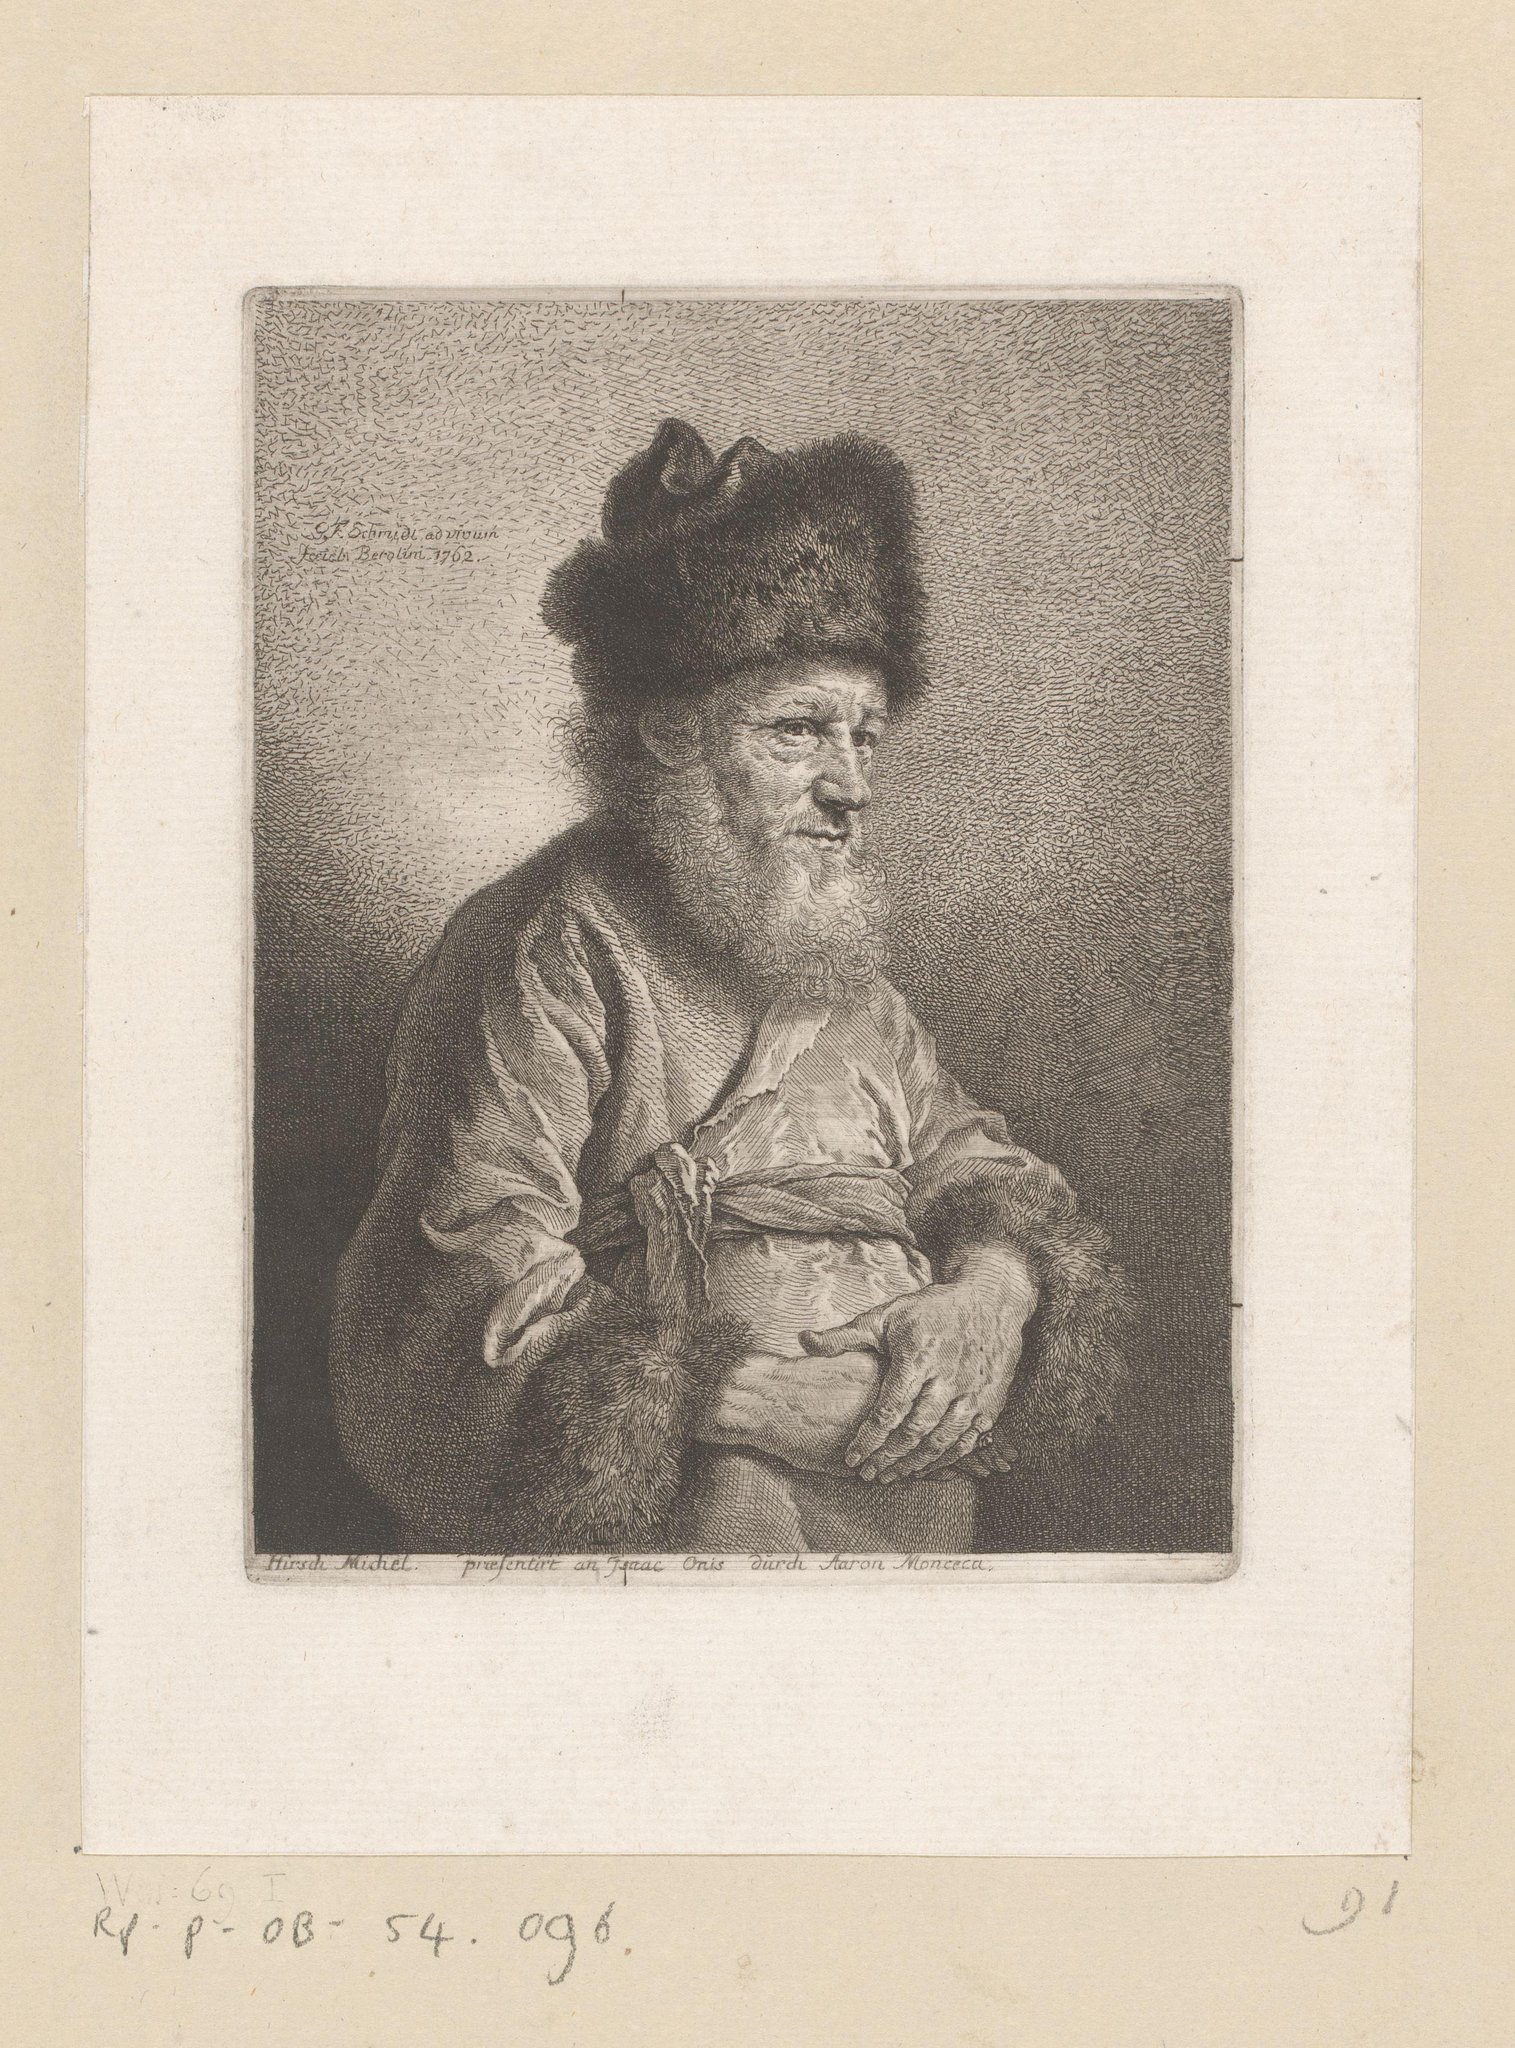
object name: print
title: Portret van Michel Hirsch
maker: georg friedrich schmidt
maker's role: draughtsman, print maker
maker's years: 1712-1775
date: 1762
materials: paper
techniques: etching, intaglio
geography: berlin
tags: historical persons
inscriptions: collector's mark: Lugt 240